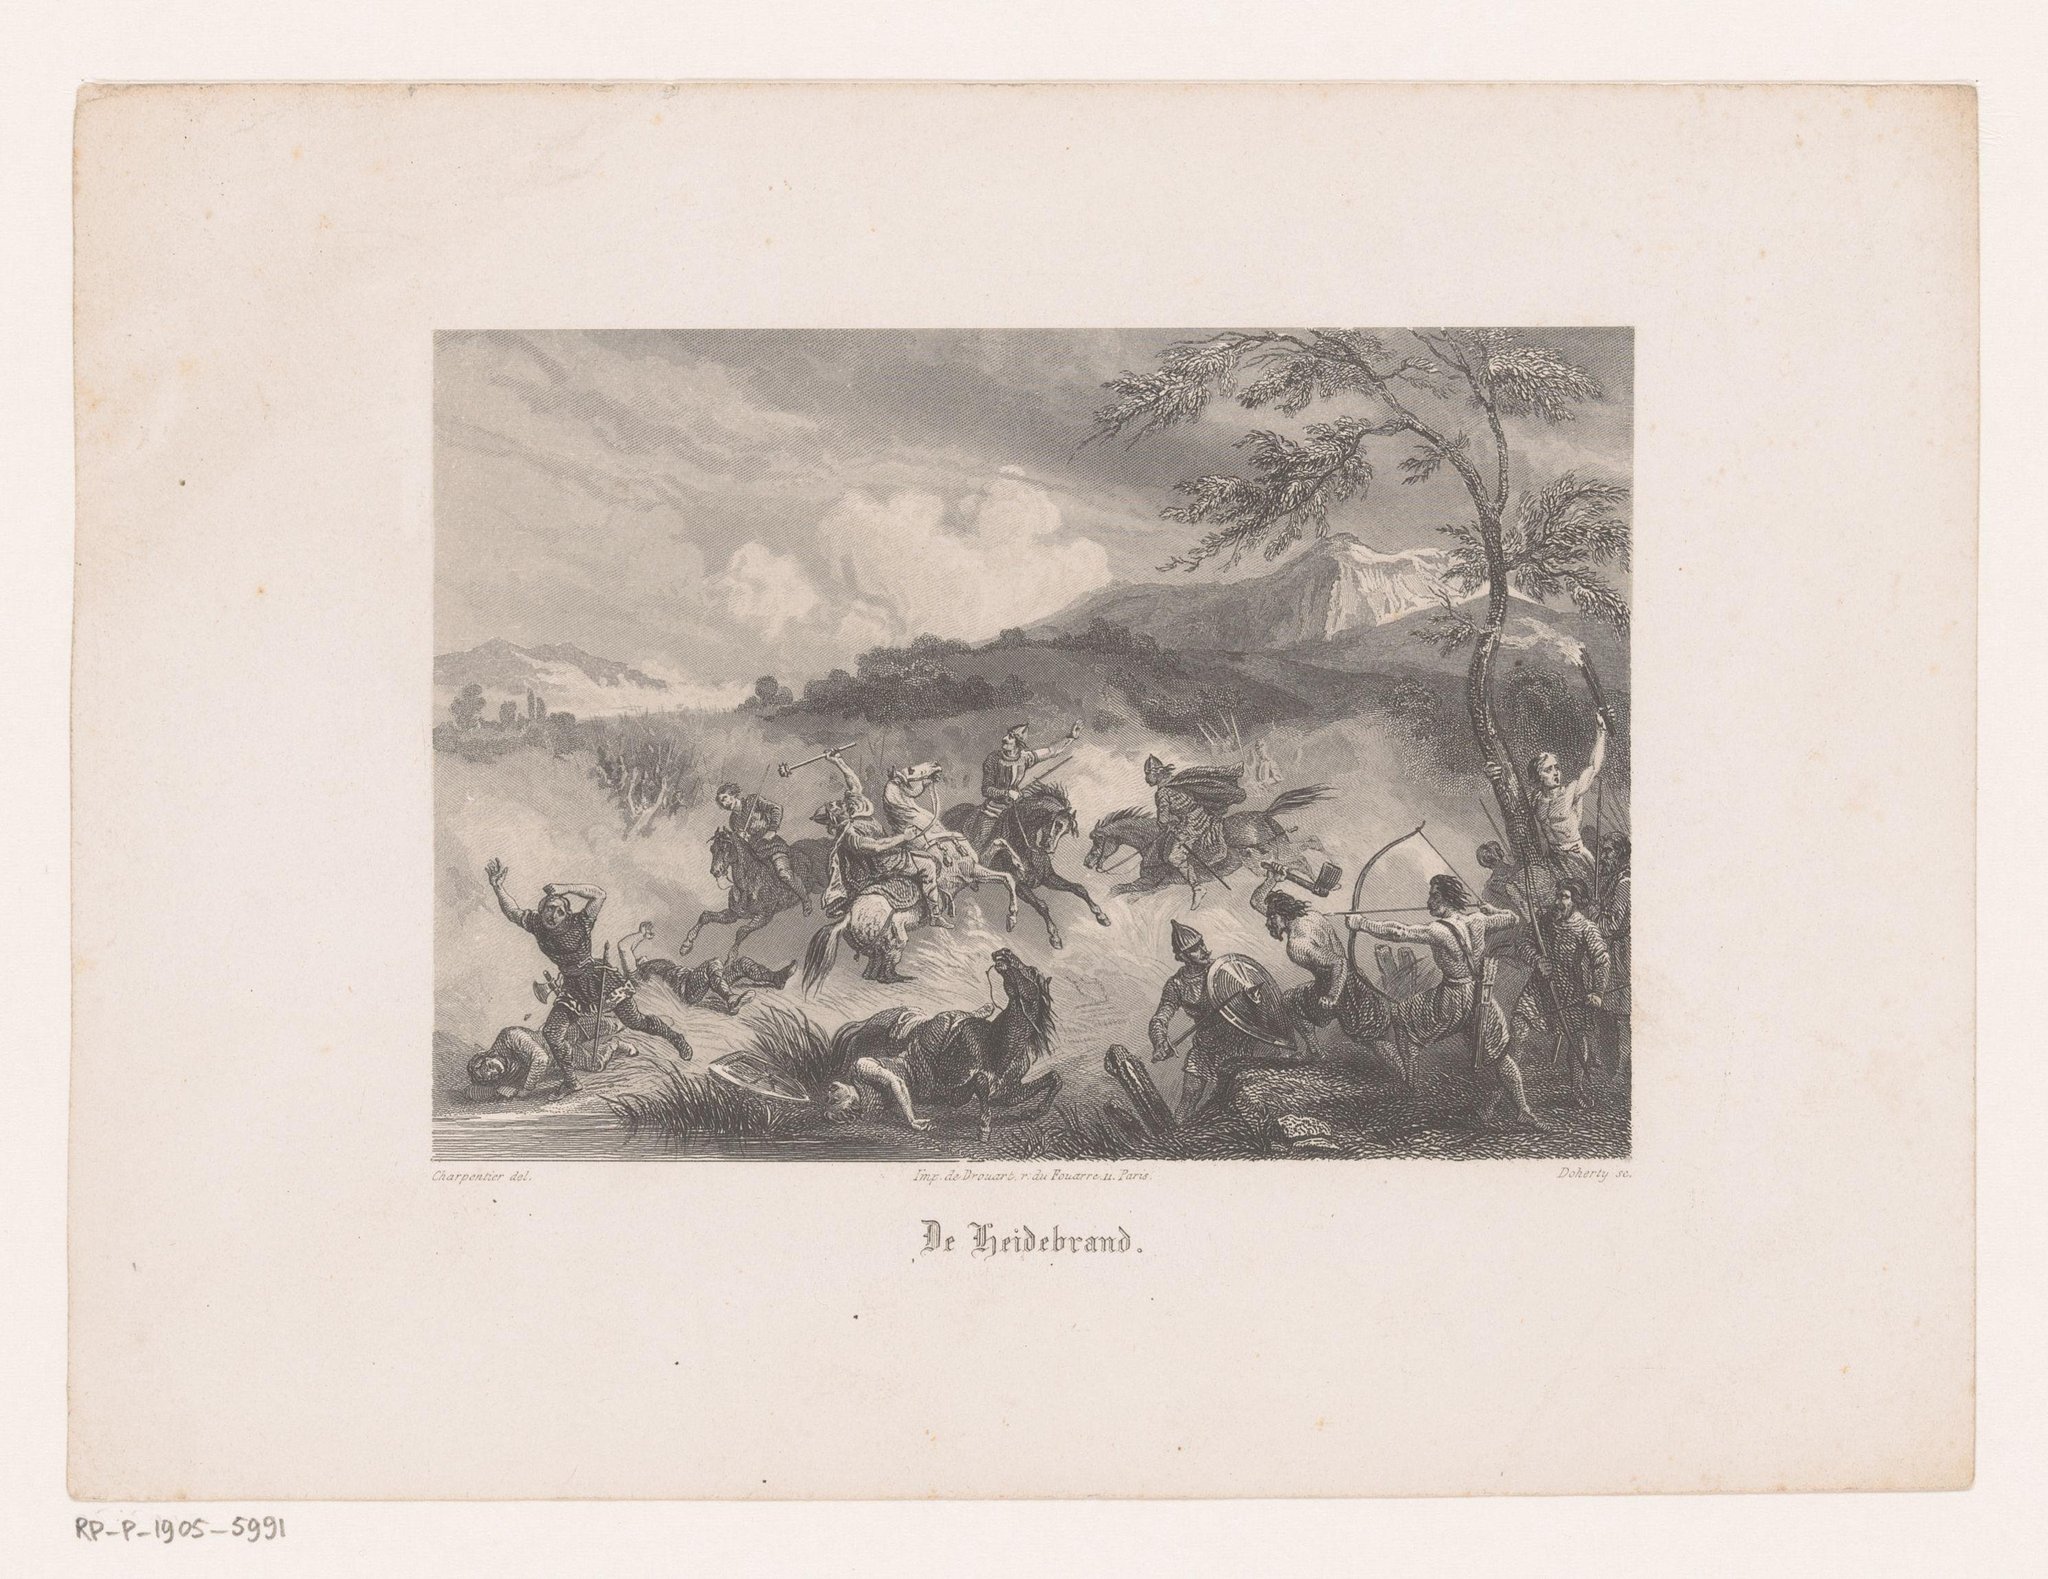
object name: print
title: Slagveld met boogschutters en cavaleristen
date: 1830-1868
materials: paper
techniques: engraving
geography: paris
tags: warfare; military affairs, archer's weapons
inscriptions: collector's mark: Lugt 2228